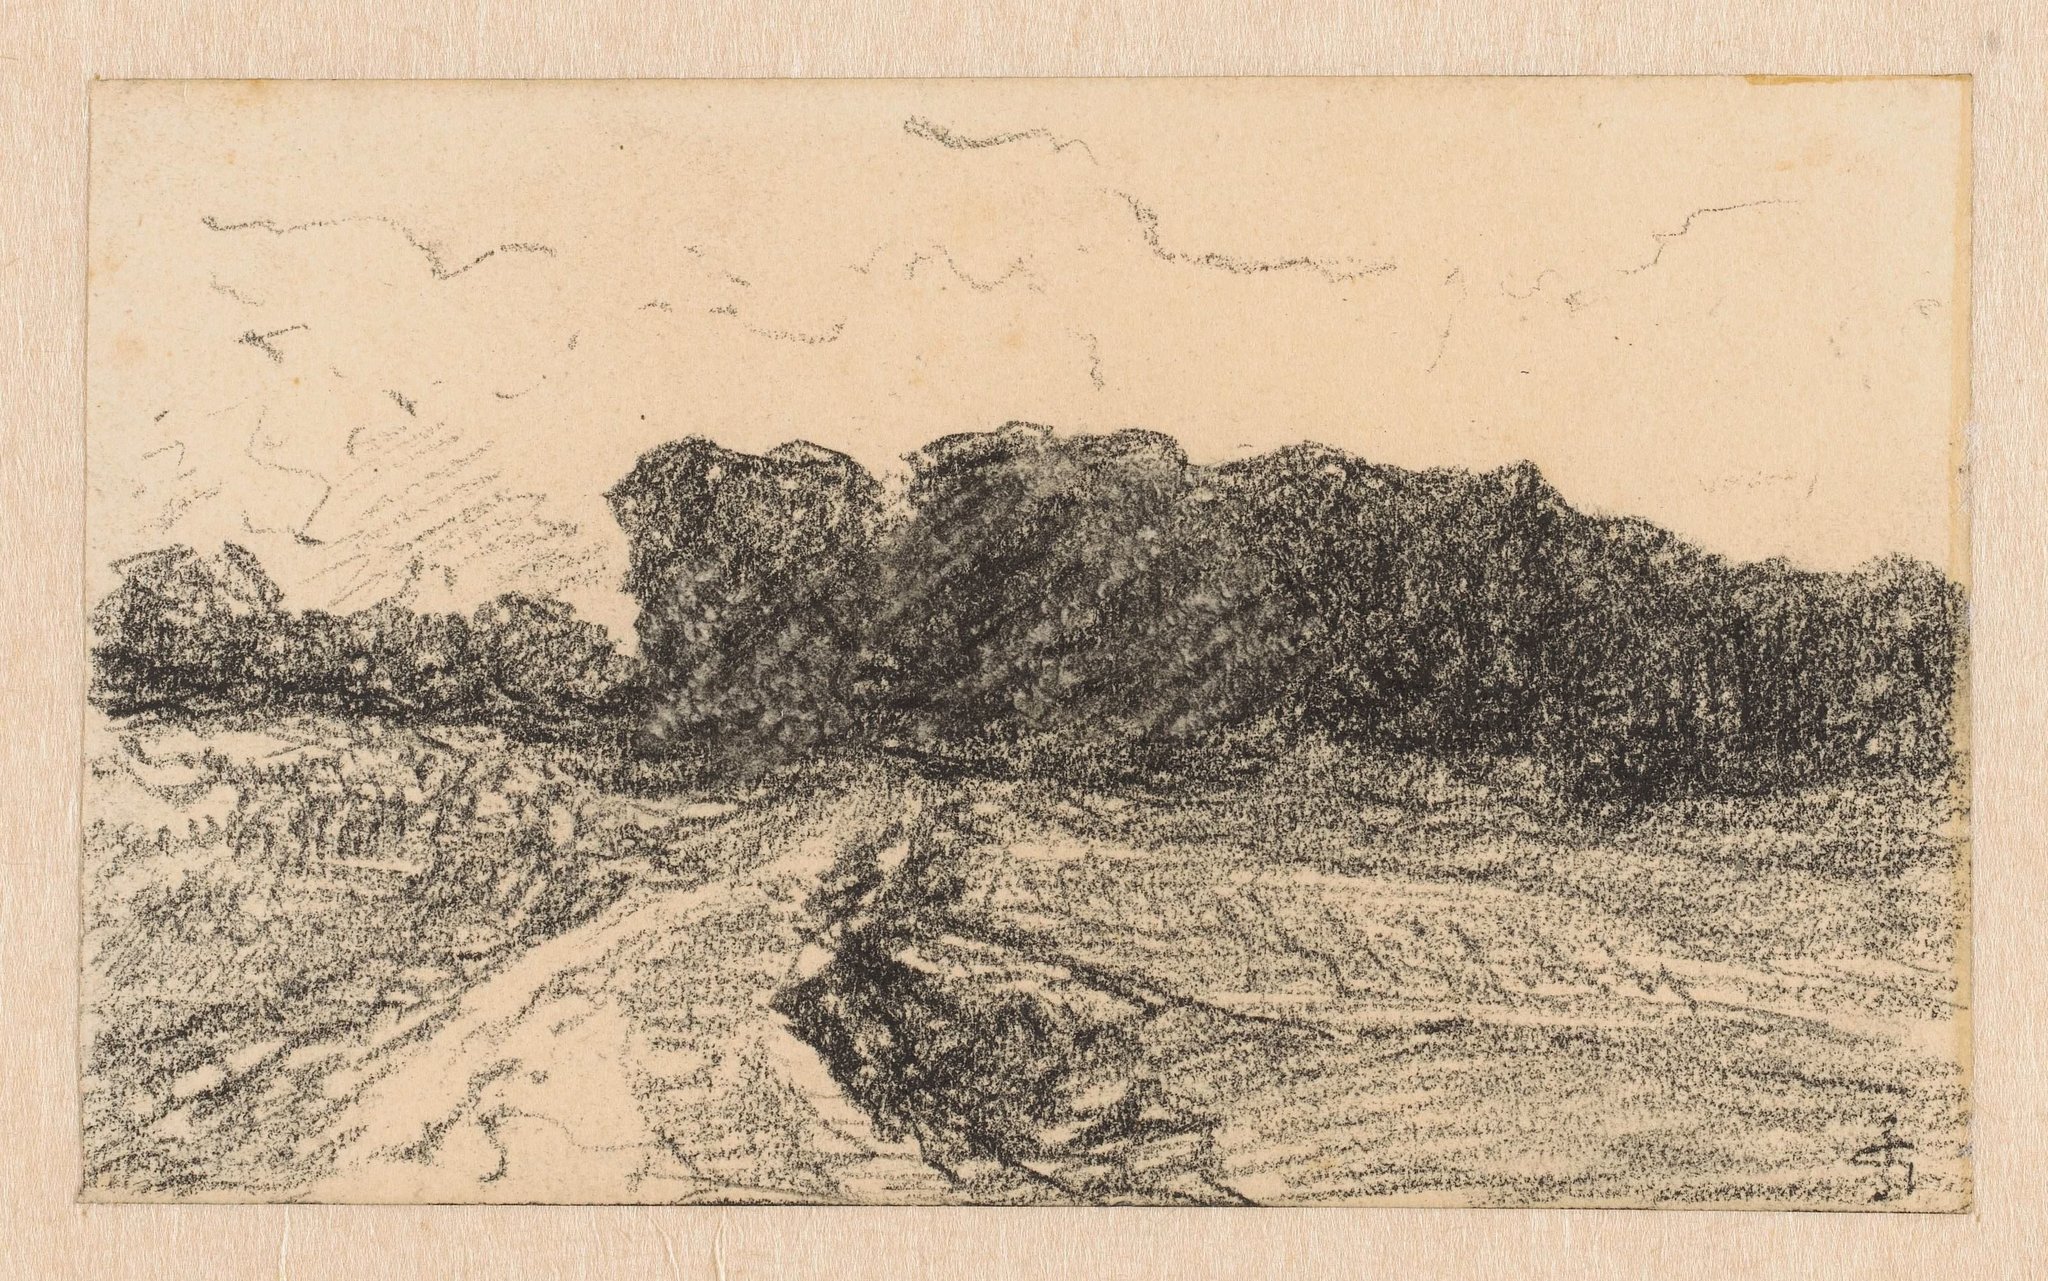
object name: drawing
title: Linden-allee, weg naar de Bresserberg te Kleve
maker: carel nicolaas storm van s-gravesande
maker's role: draughtsman, print maker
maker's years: 1841-1924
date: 1851-1924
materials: chalk, paper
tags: public road, cleves